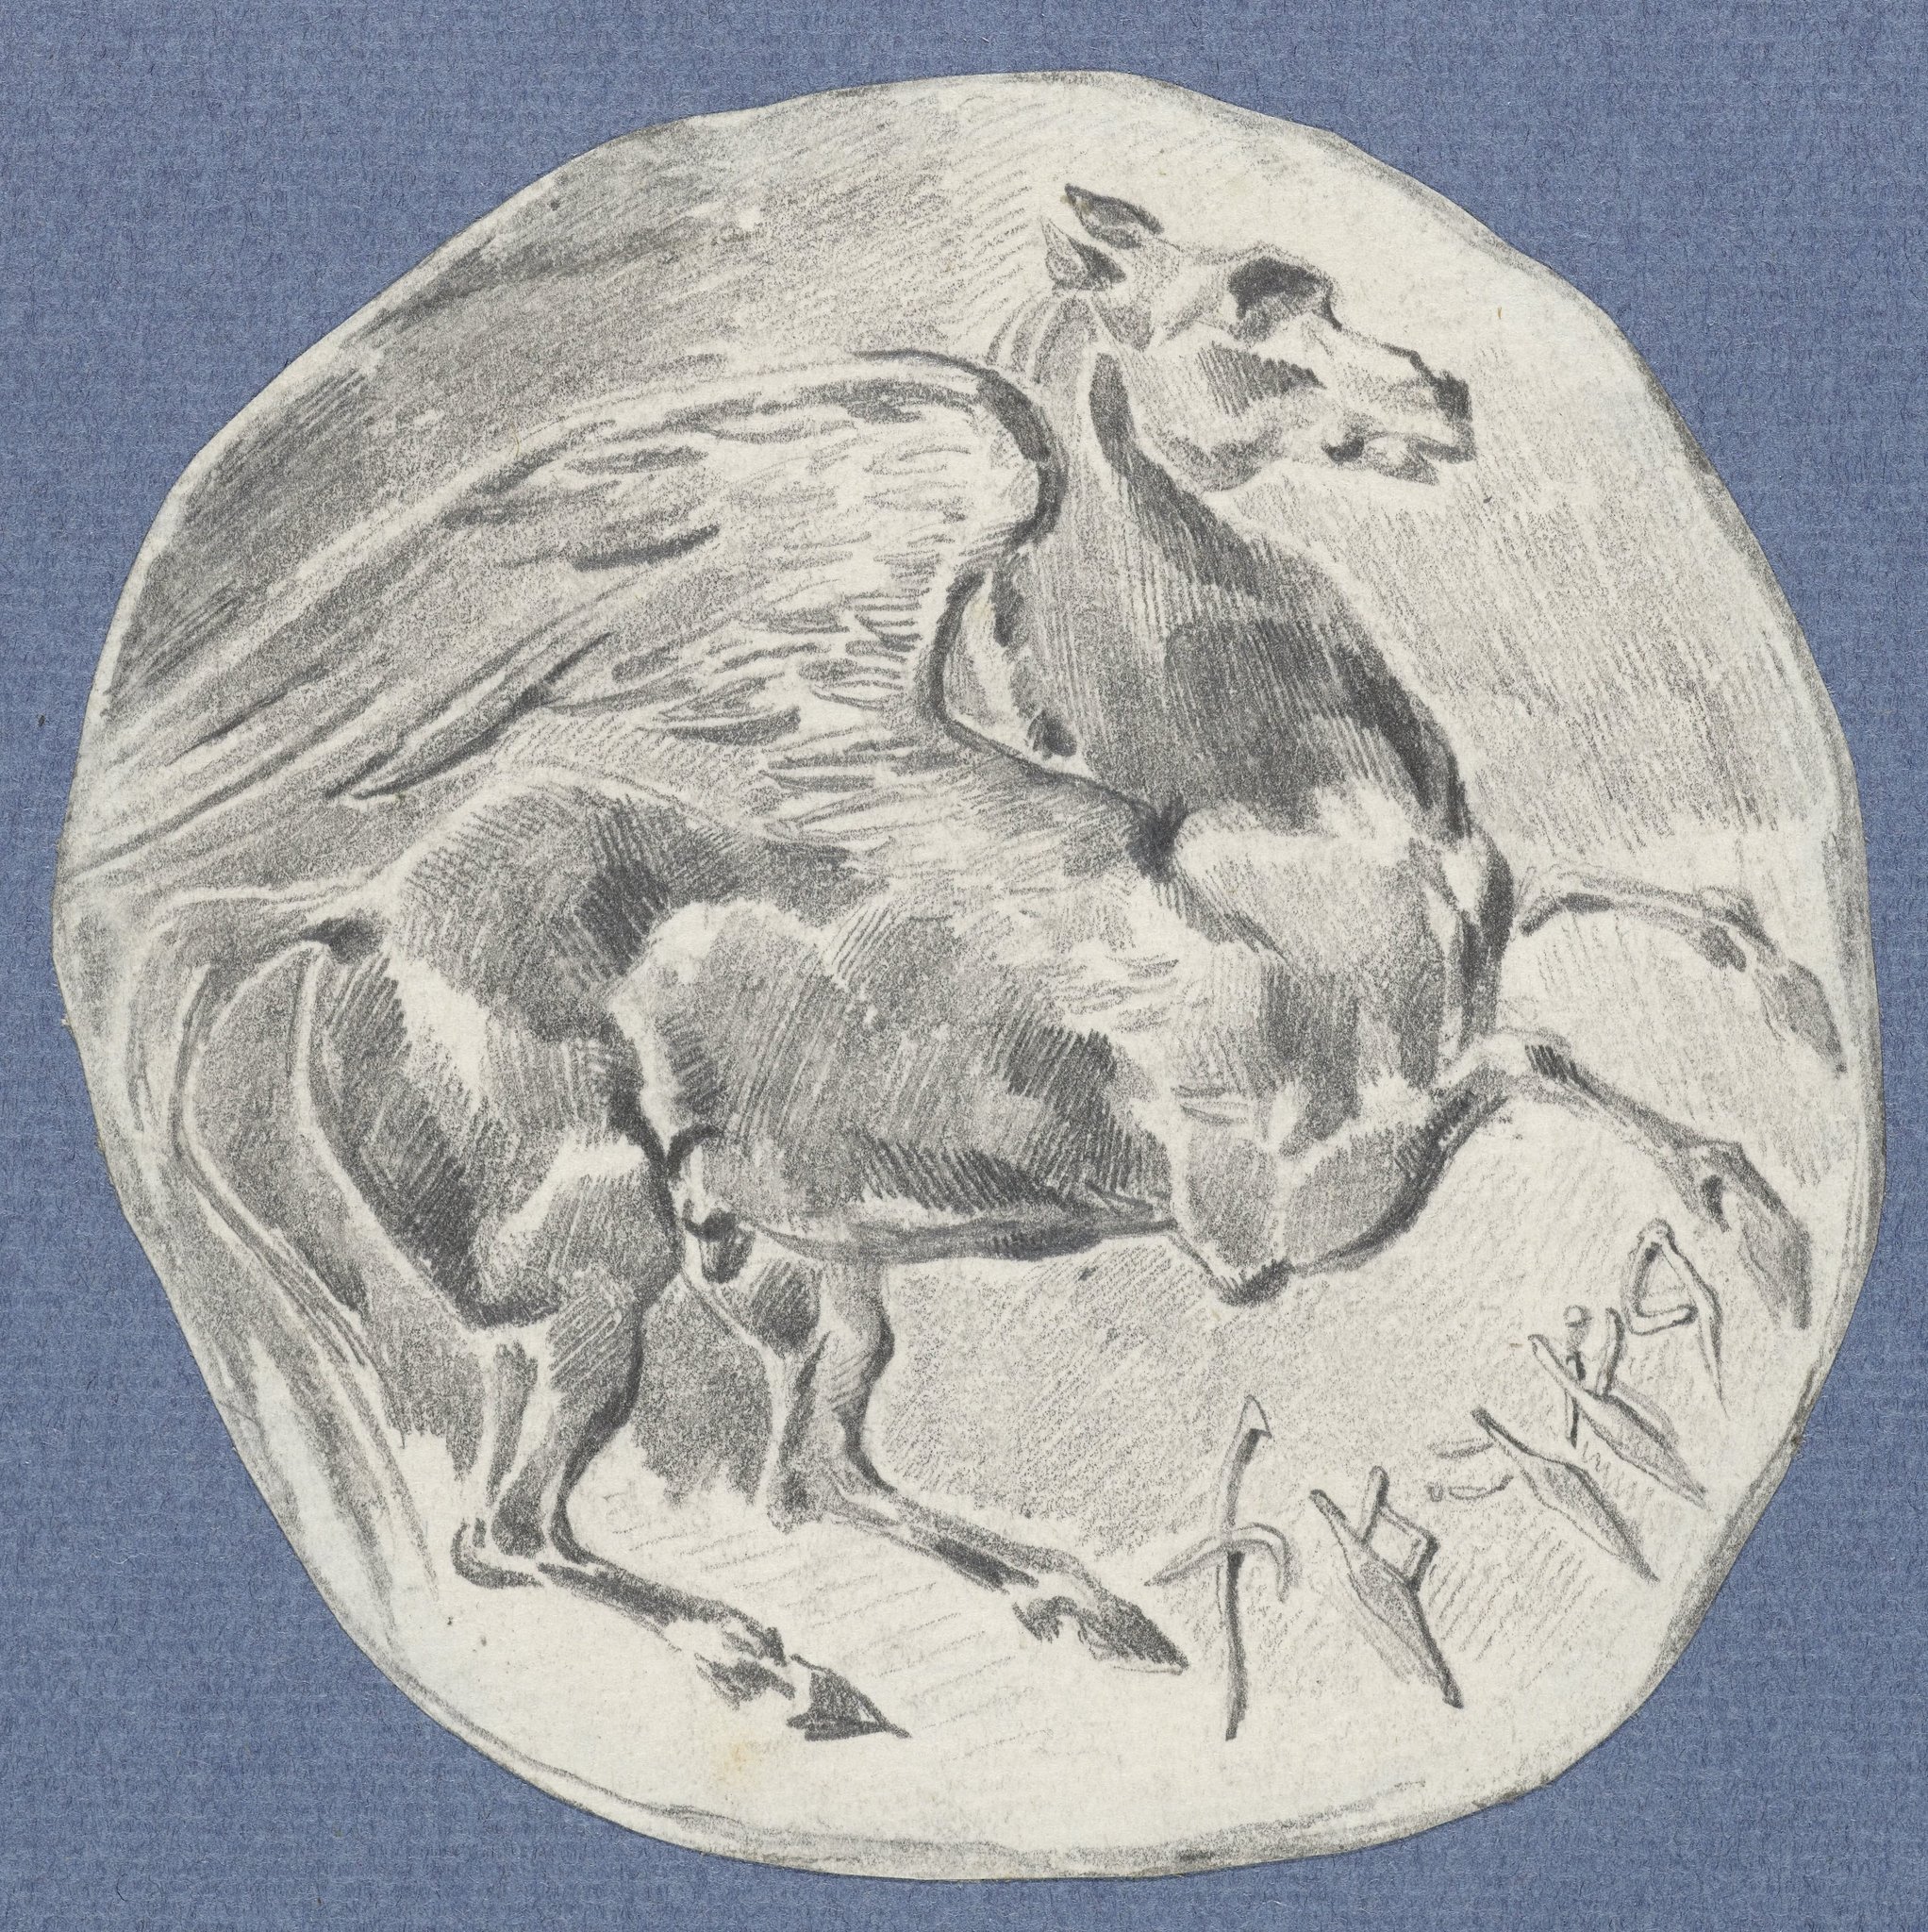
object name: drawing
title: Hoofd van Persephone met dubbele aar in het haar, in profiel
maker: eugène delacroix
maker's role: draughtsman, print maker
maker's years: 1798-1863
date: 1825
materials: paper, pencil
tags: (story of) proserpina (persephone, core), libera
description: Afbeelding van de voorzijde van een grote (Carthageense?) munt: het hoofd van Persephone met dubbele aar in het haar, in profiel.